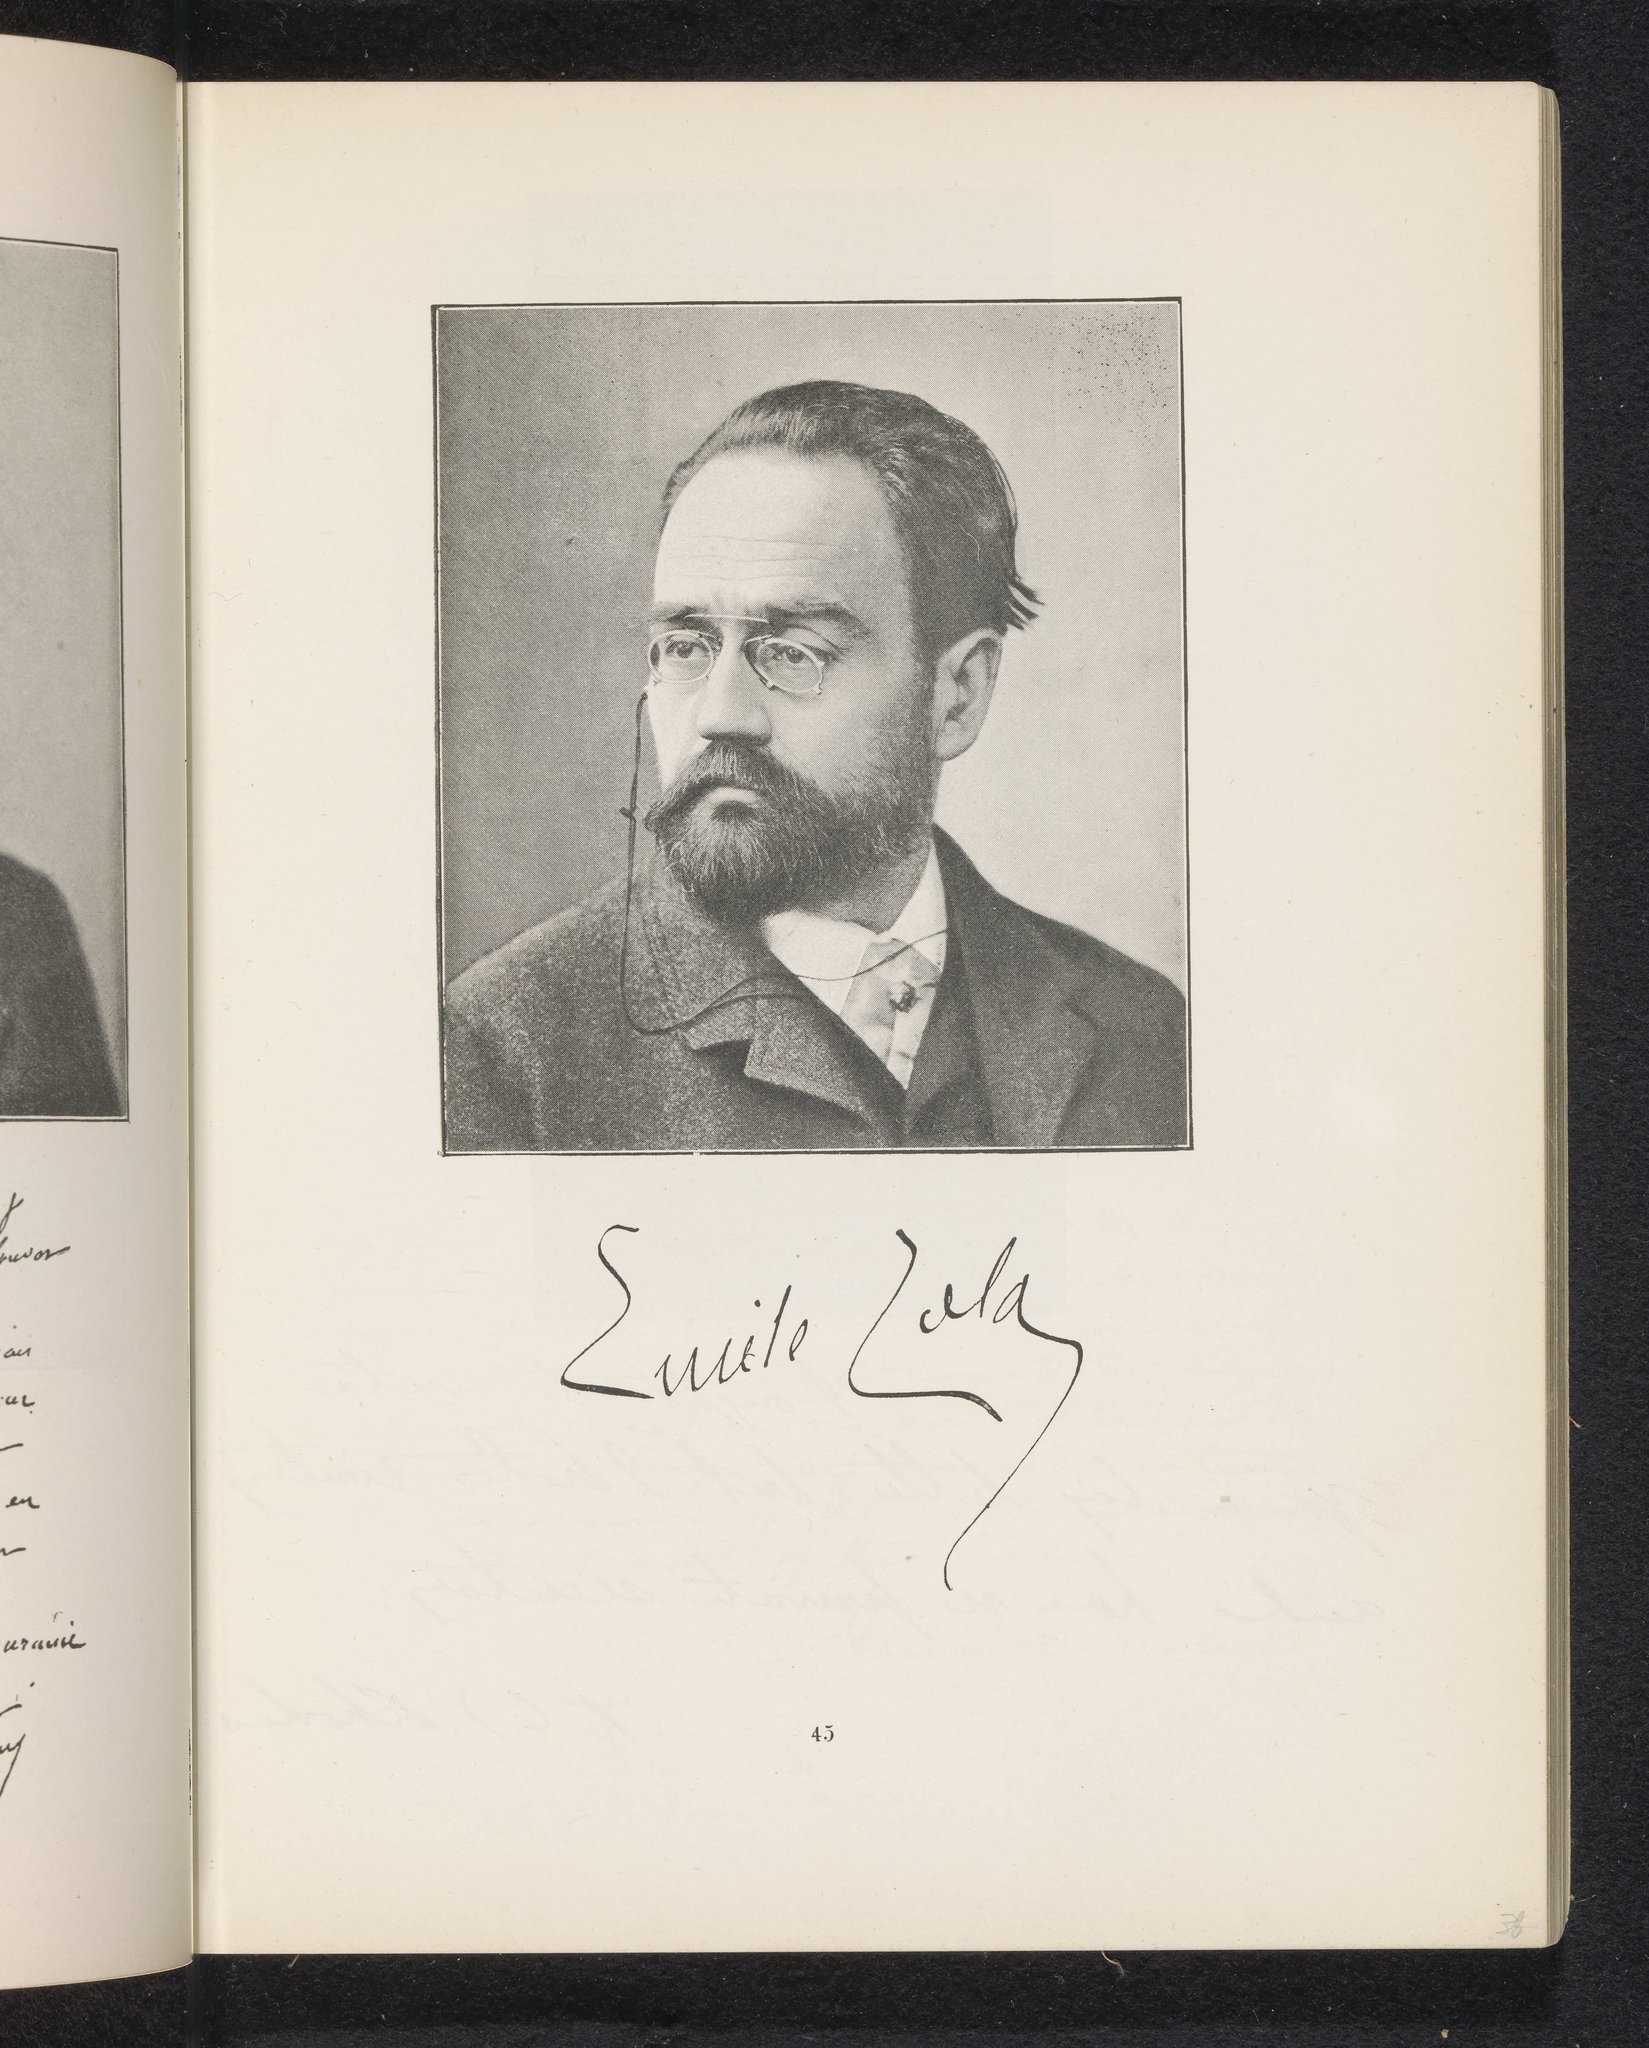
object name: photomechanical print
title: Portret van Emile Zola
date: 1881-1891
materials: paper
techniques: autotype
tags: emile zola, portrait of a writer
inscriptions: inscription